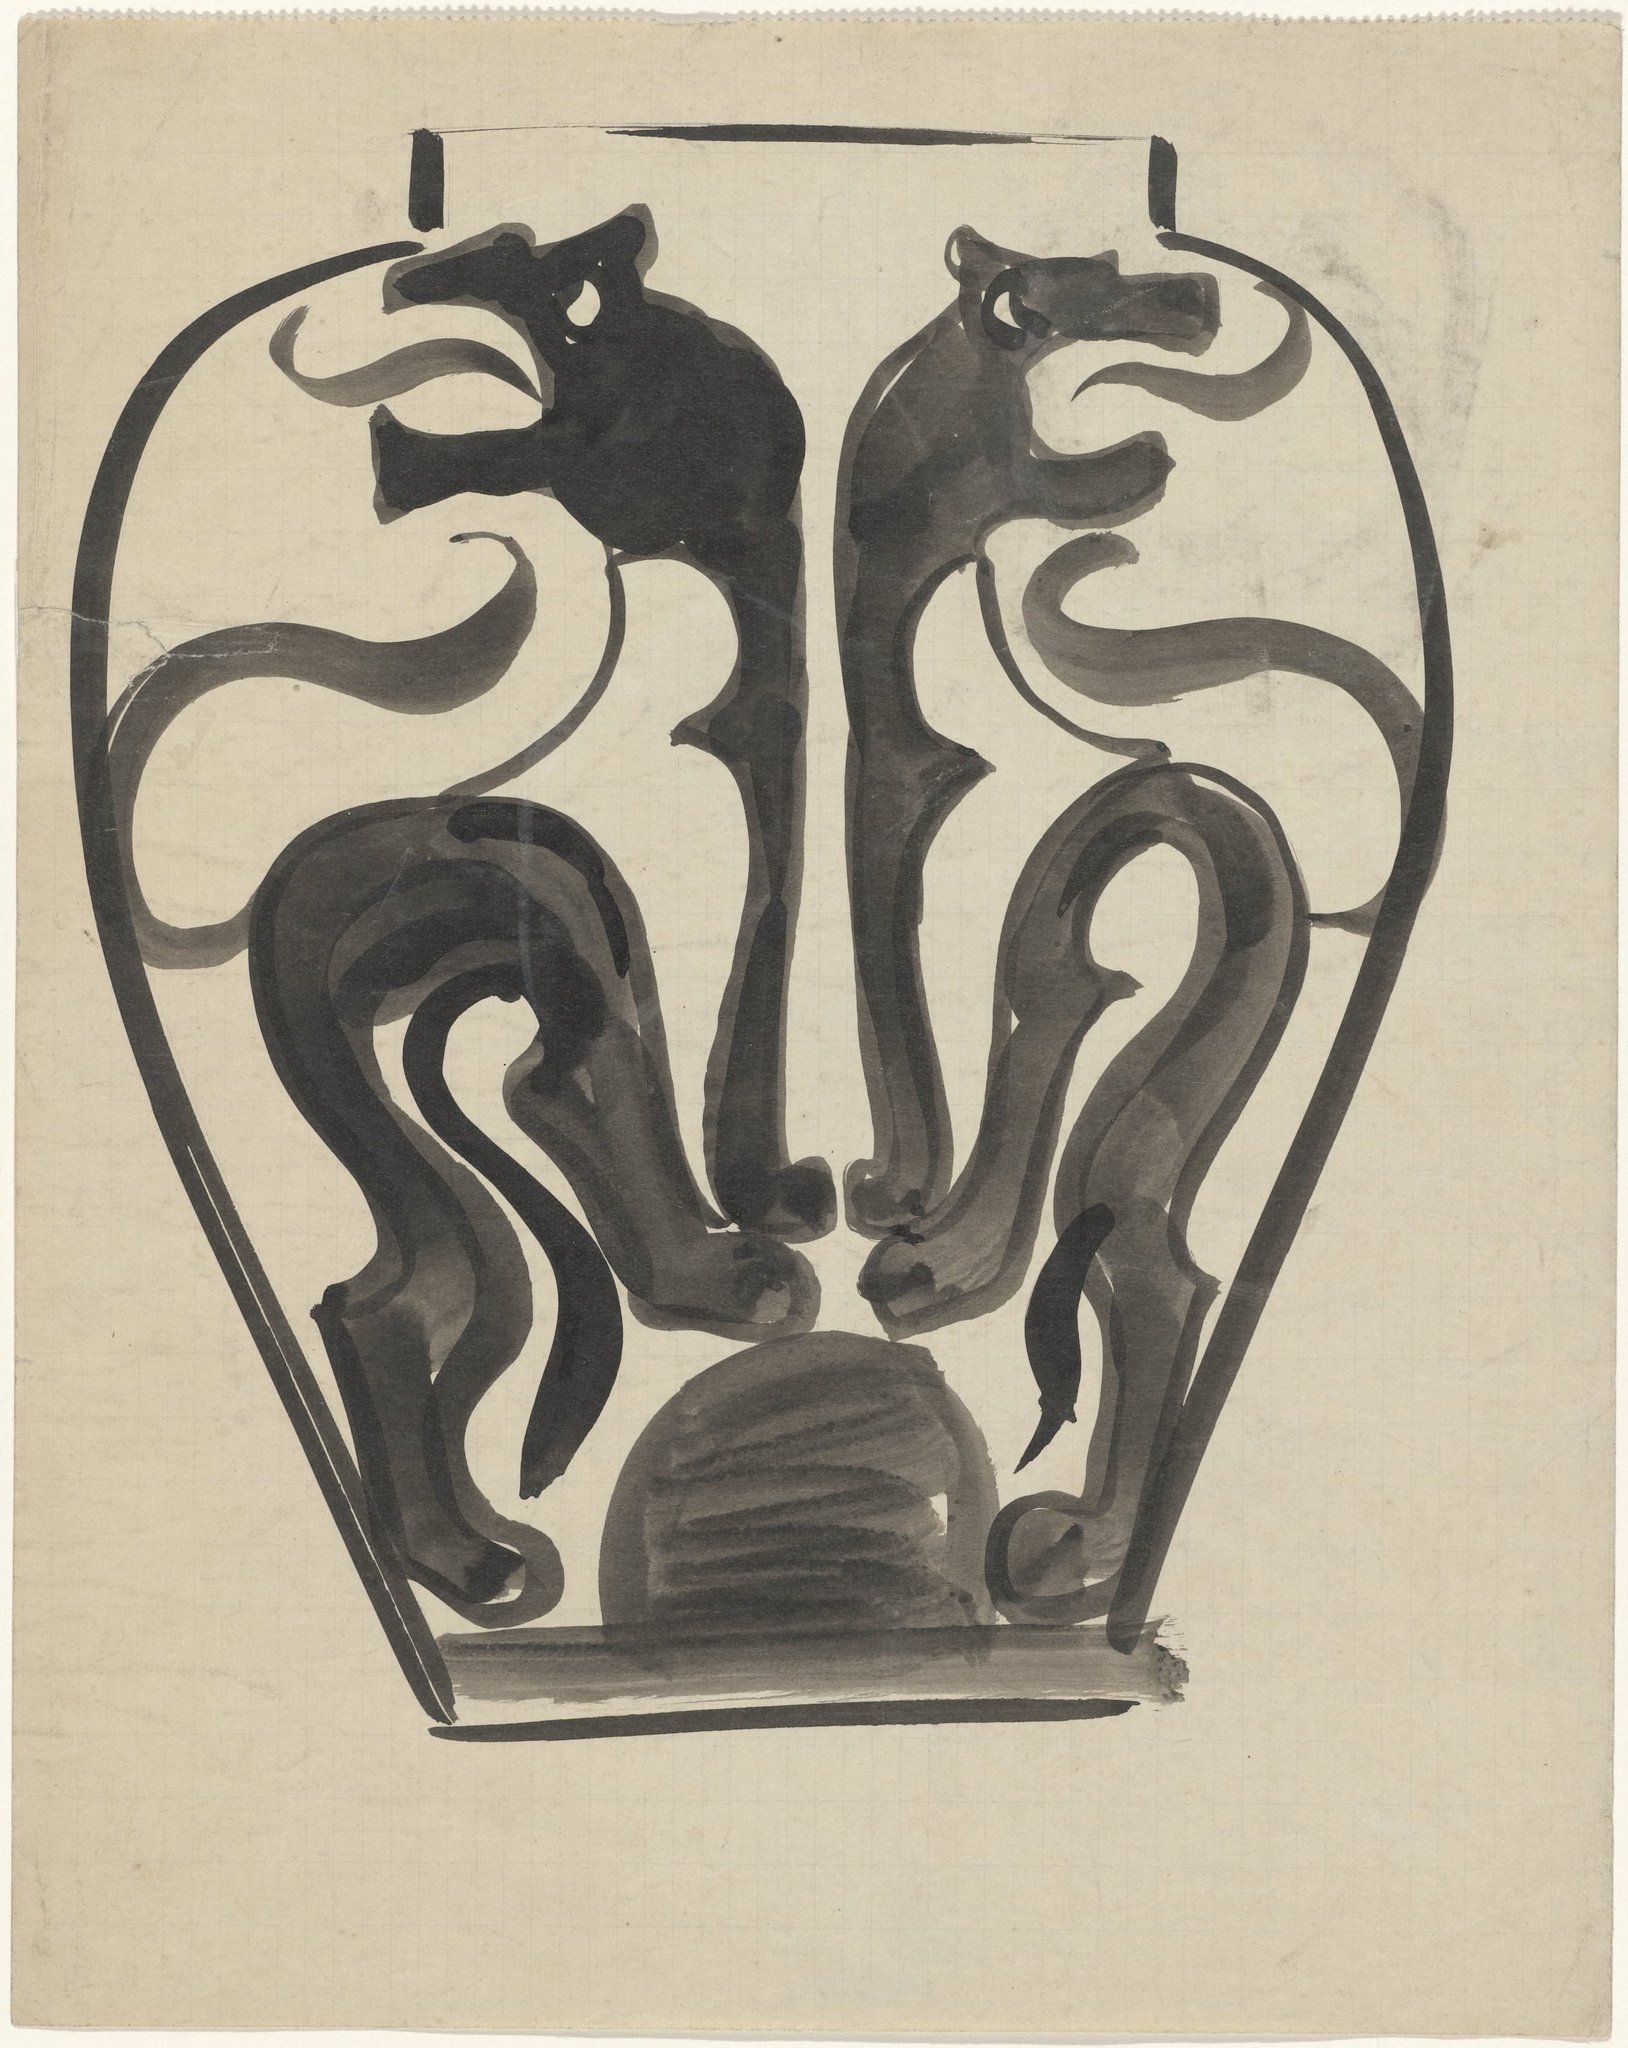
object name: design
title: Ontwerp voor een vaas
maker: carel adolph lion cachet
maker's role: draughtsman, print maker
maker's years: 1864-1945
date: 1874-1945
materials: squared paper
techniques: brush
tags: work of applied art (+ ceramics ~ arts), container of ceramics: jar, jug, pot, vase